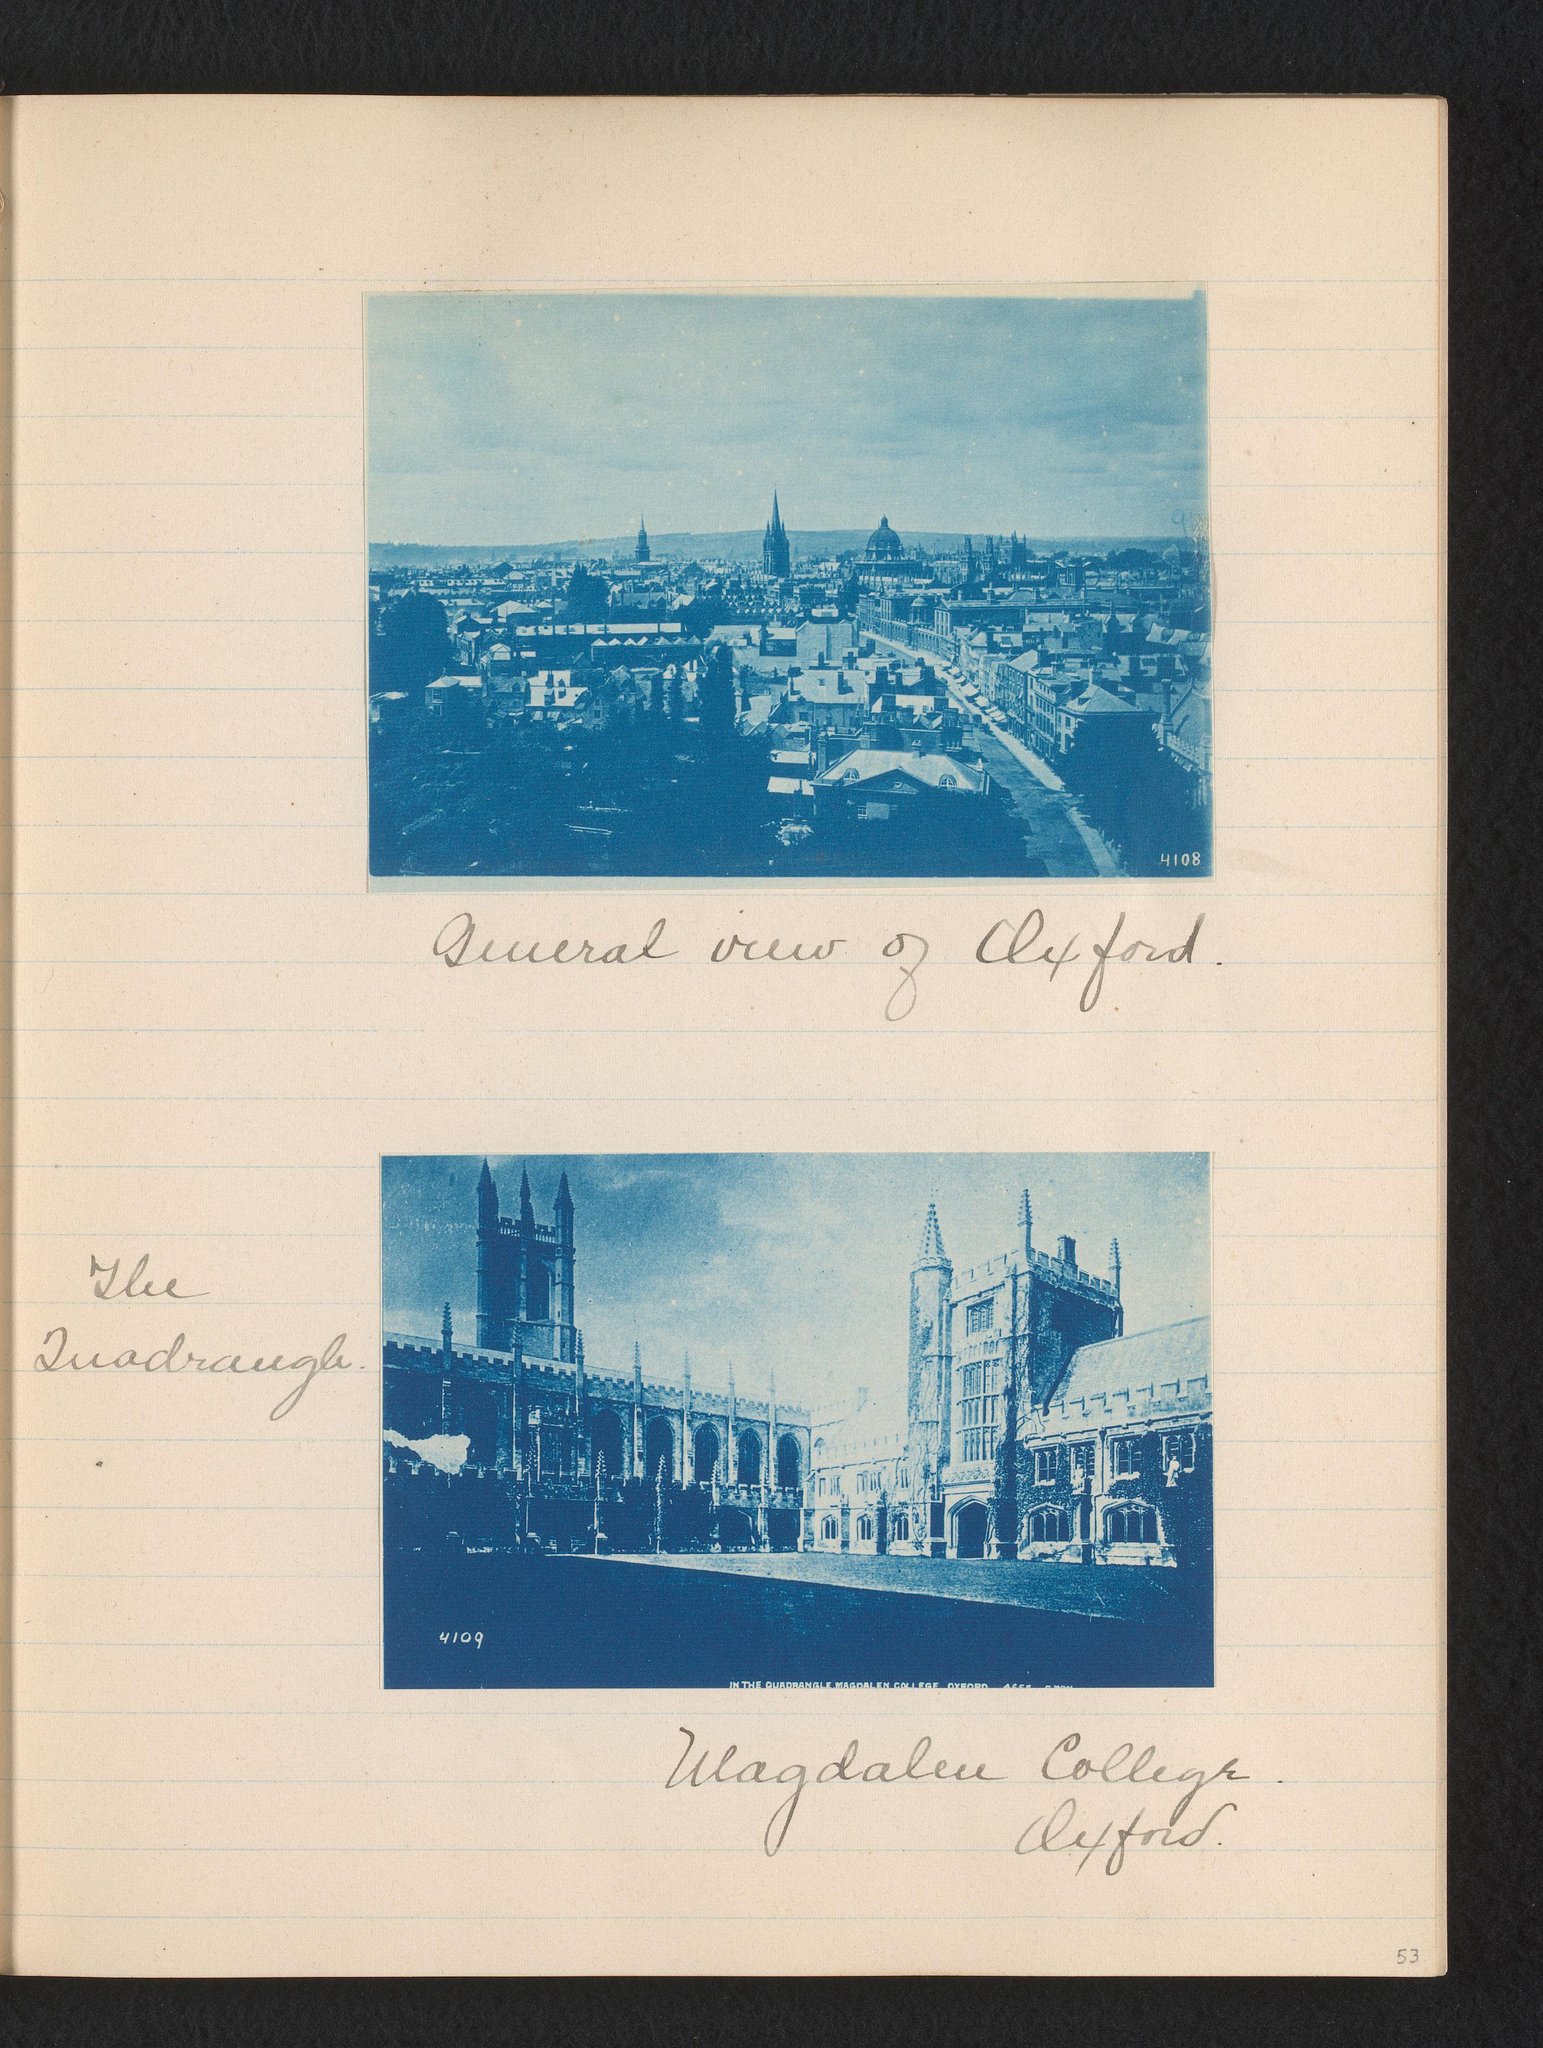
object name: album leaf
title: Twee foto's van een gezicht op Oxford en Magdalen College aldaar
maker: Anonymous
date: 1901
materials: paper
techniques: cyanotype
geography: oxford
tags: city-view in general; 'veduta', university building, college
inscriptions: inscription: ‘General view of Oxford./ The Quadrangle/ Magdalen College,/ Oxford.’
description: Deze foto's maken deel uit van een album.